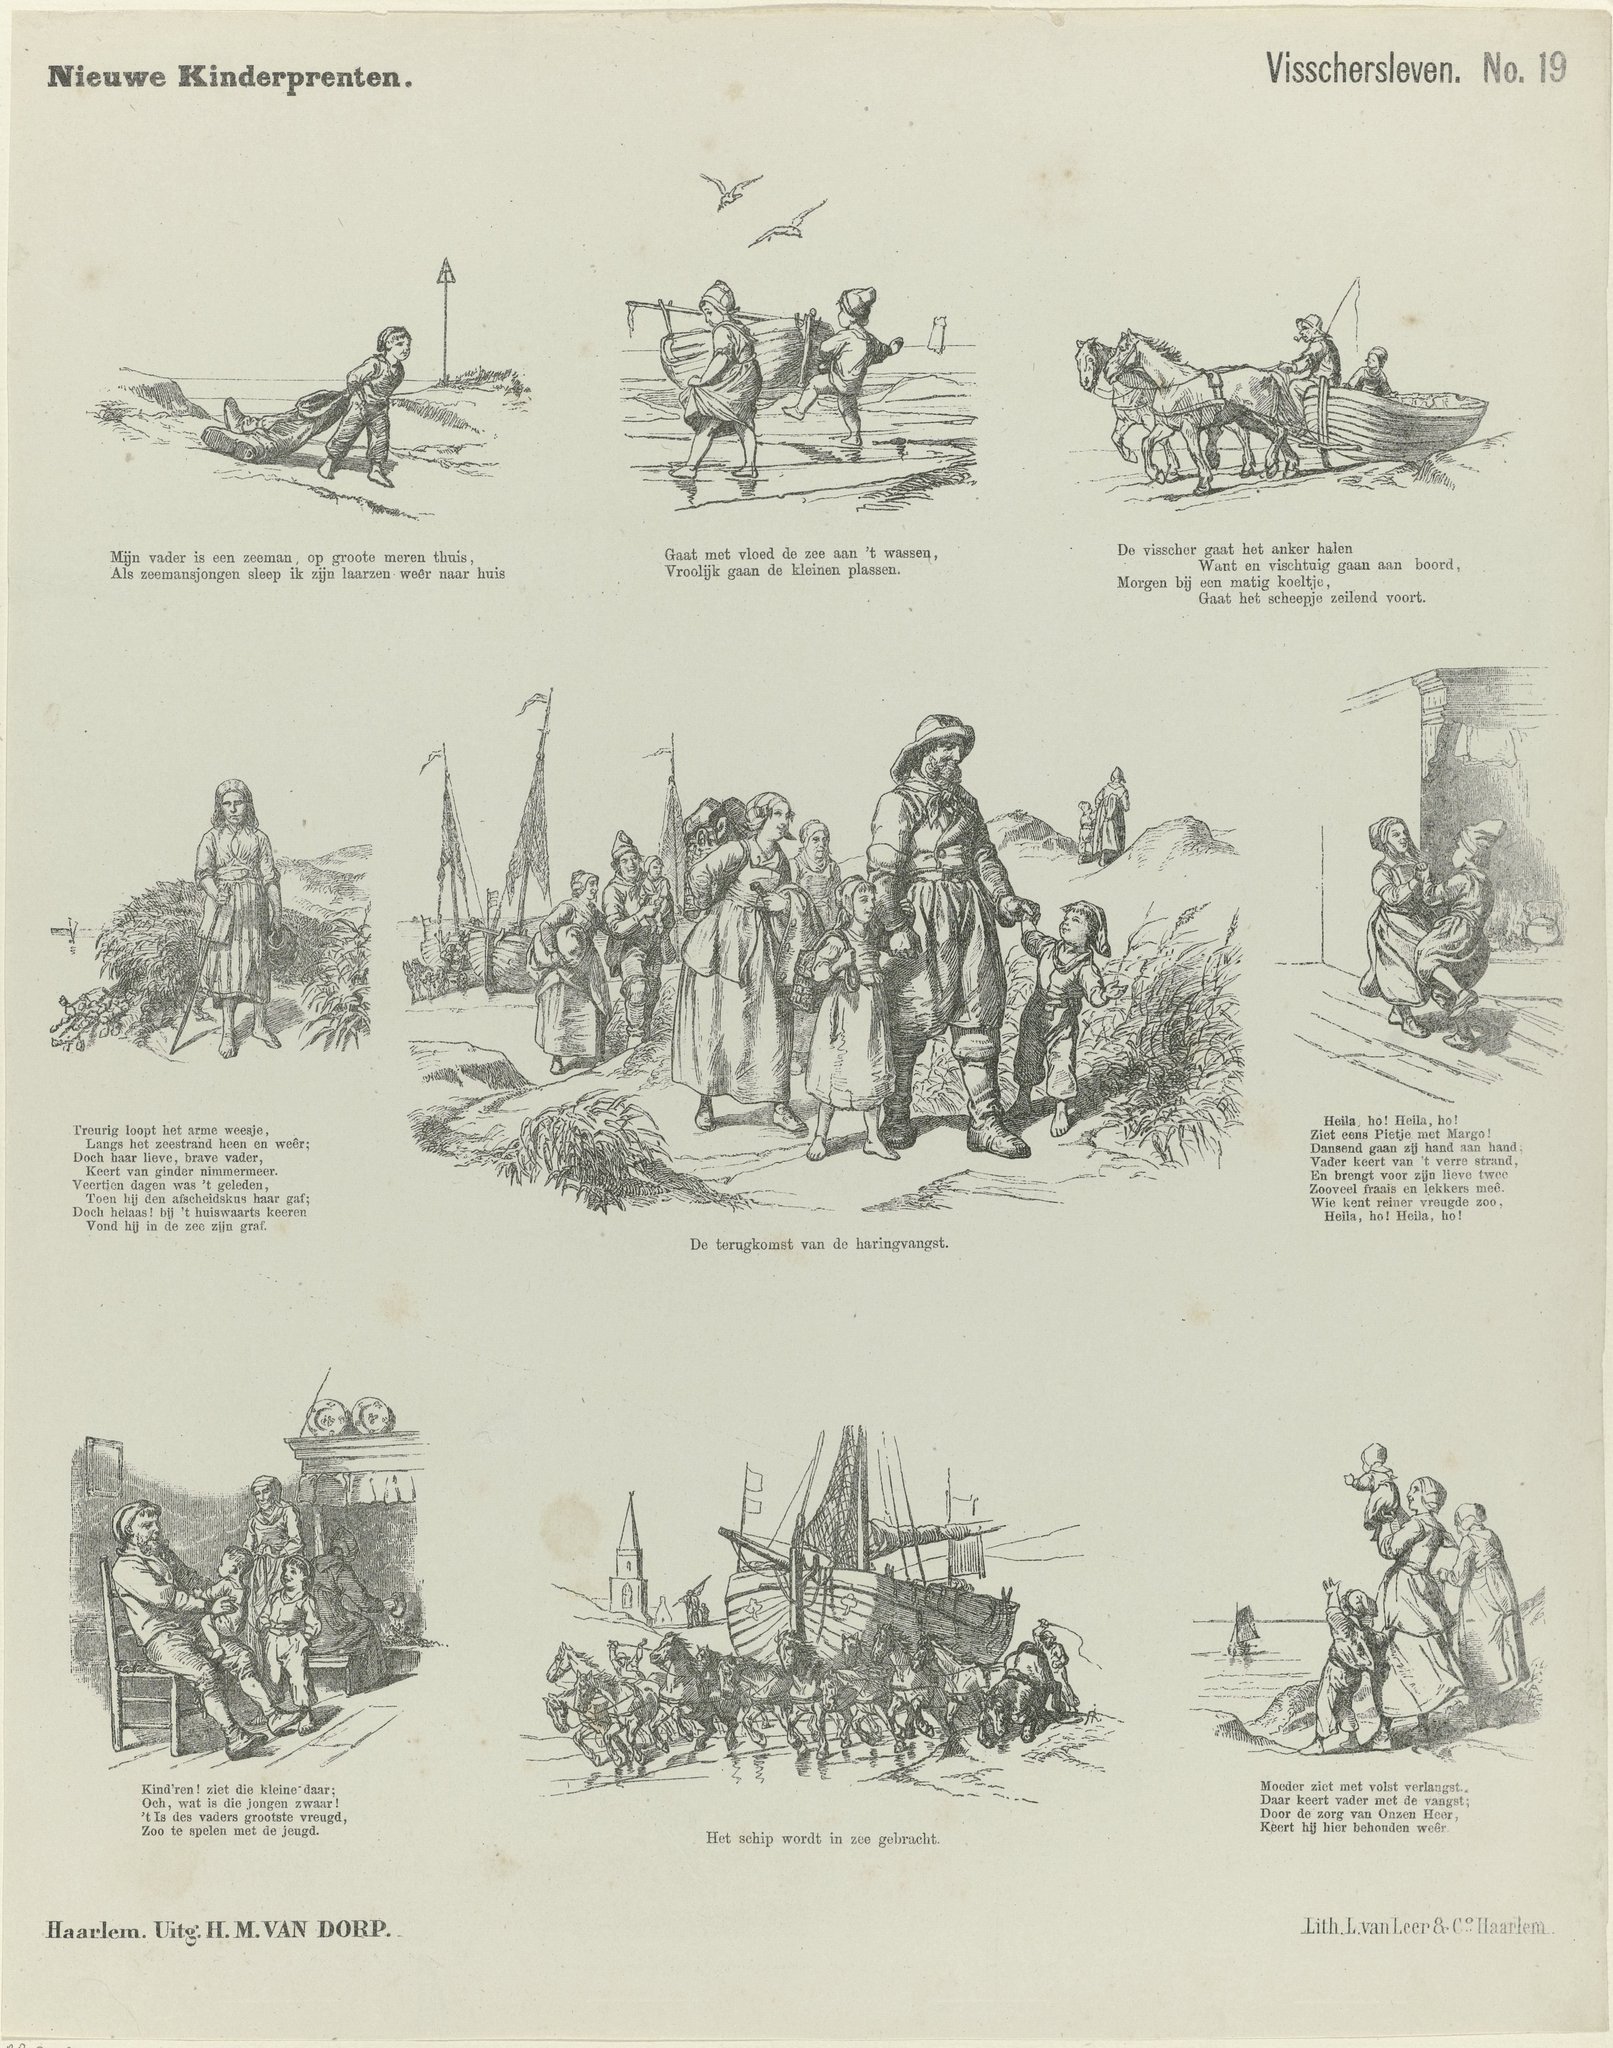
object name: print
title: Visschersleven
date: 1872-1883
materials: paper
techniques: letterpress printing, lithograph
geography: haarlem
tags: ships (in general), fisherman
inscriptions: collector's mark: Lugt 2760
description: Blad met 9 voorstellingen over het leven van een visser en zijn familie. Onder elke afbeelding een onderschrift. Genummerd rechtsboven: No. 19.